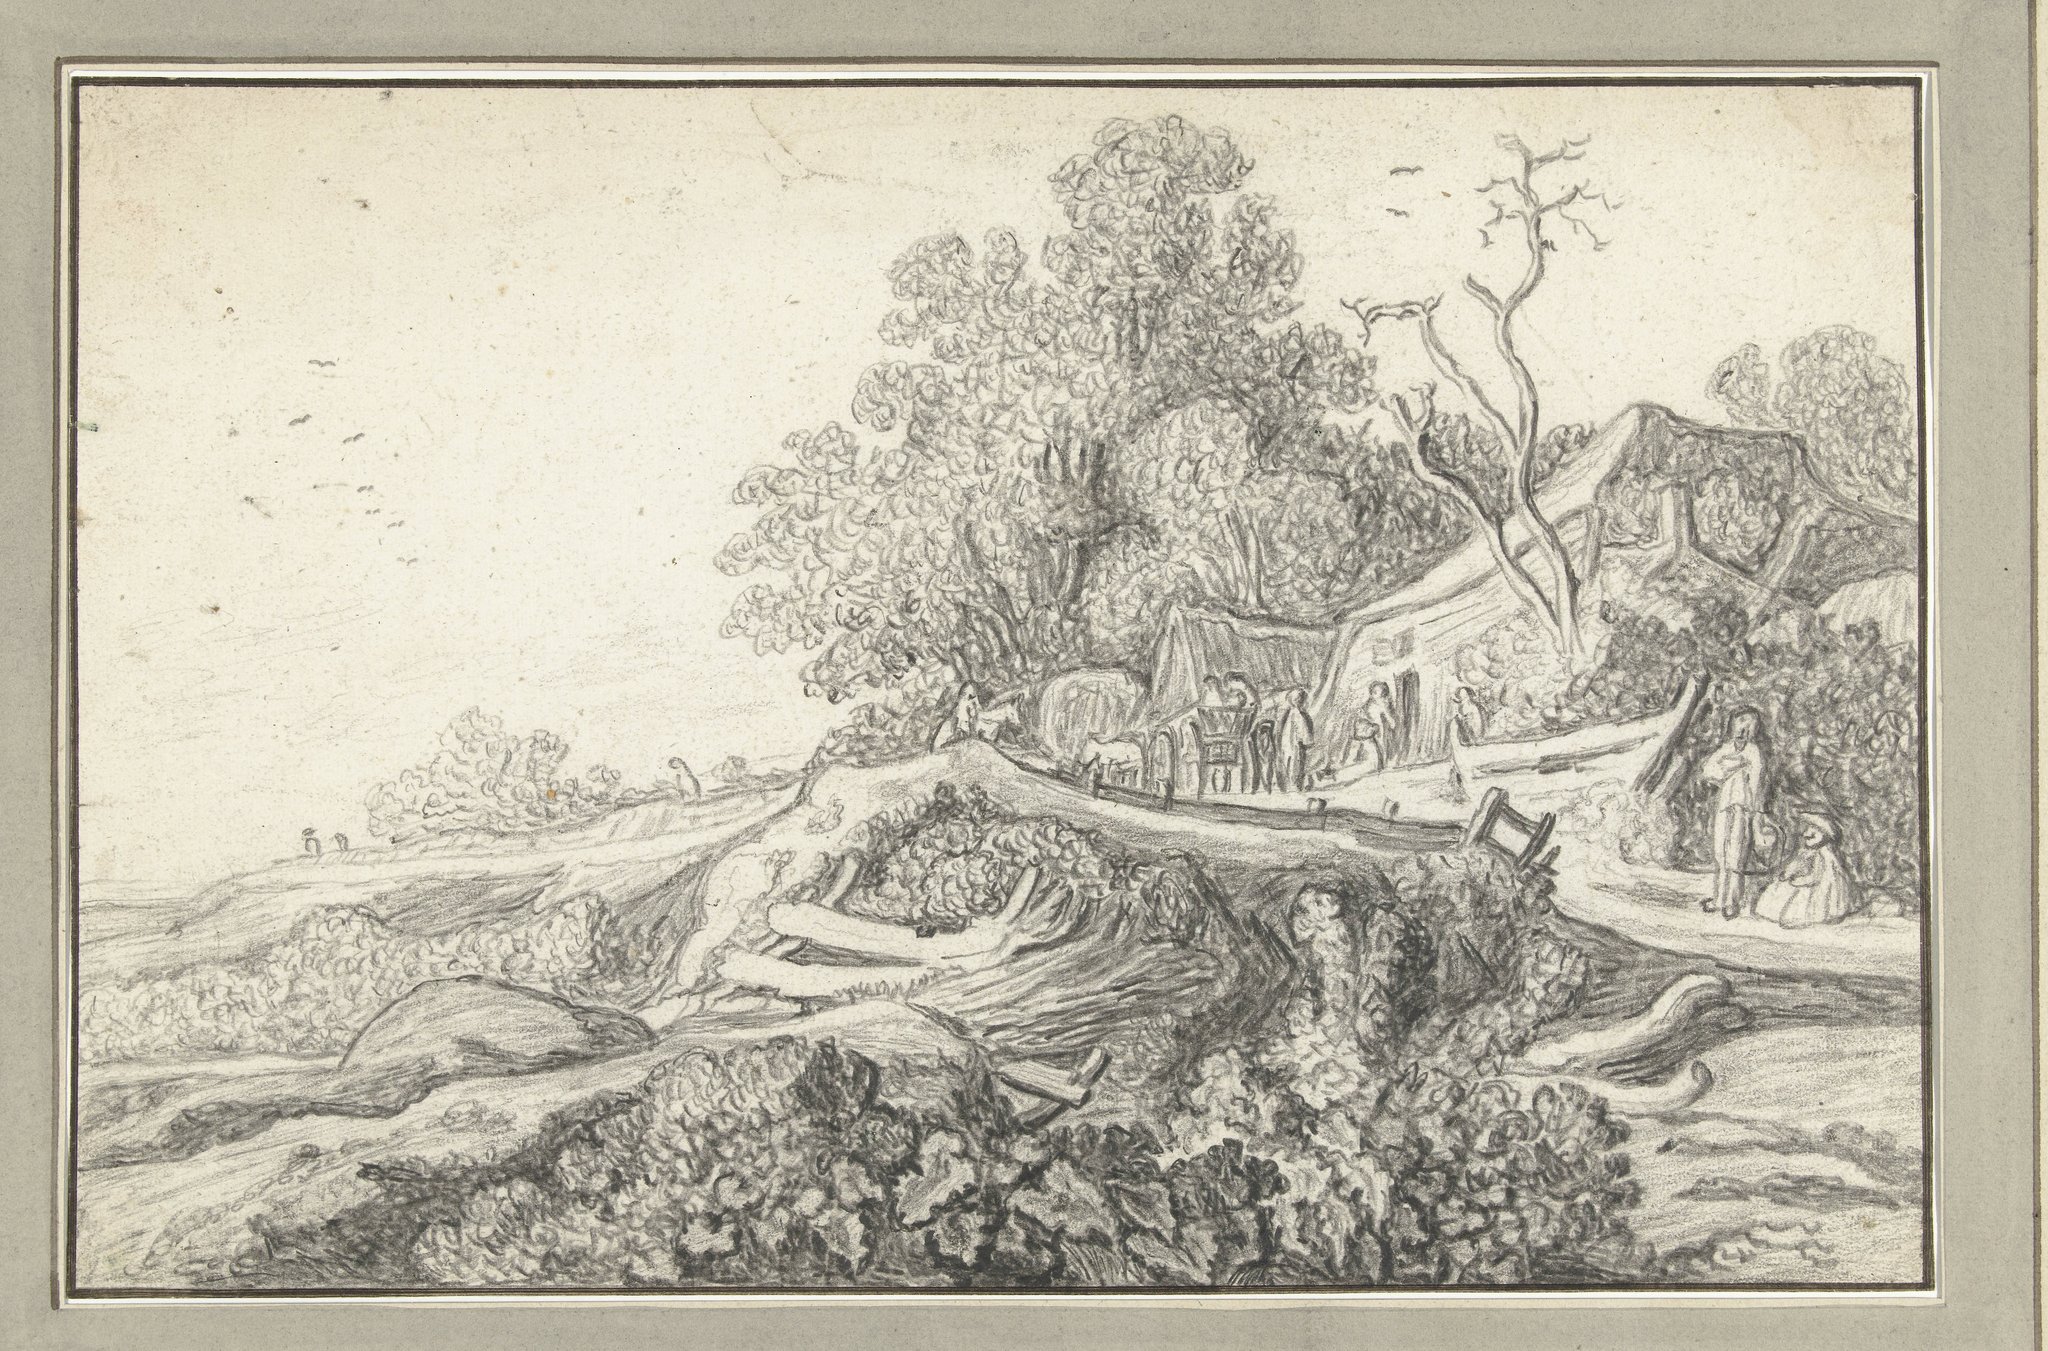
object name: drawing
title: Landschap met een kar en figuren bij een boerderij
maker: Anonymous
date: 1600-1699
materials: chalk, paper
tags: farm or solitary house in landscape, (farm) wagon, freight wagon, cart